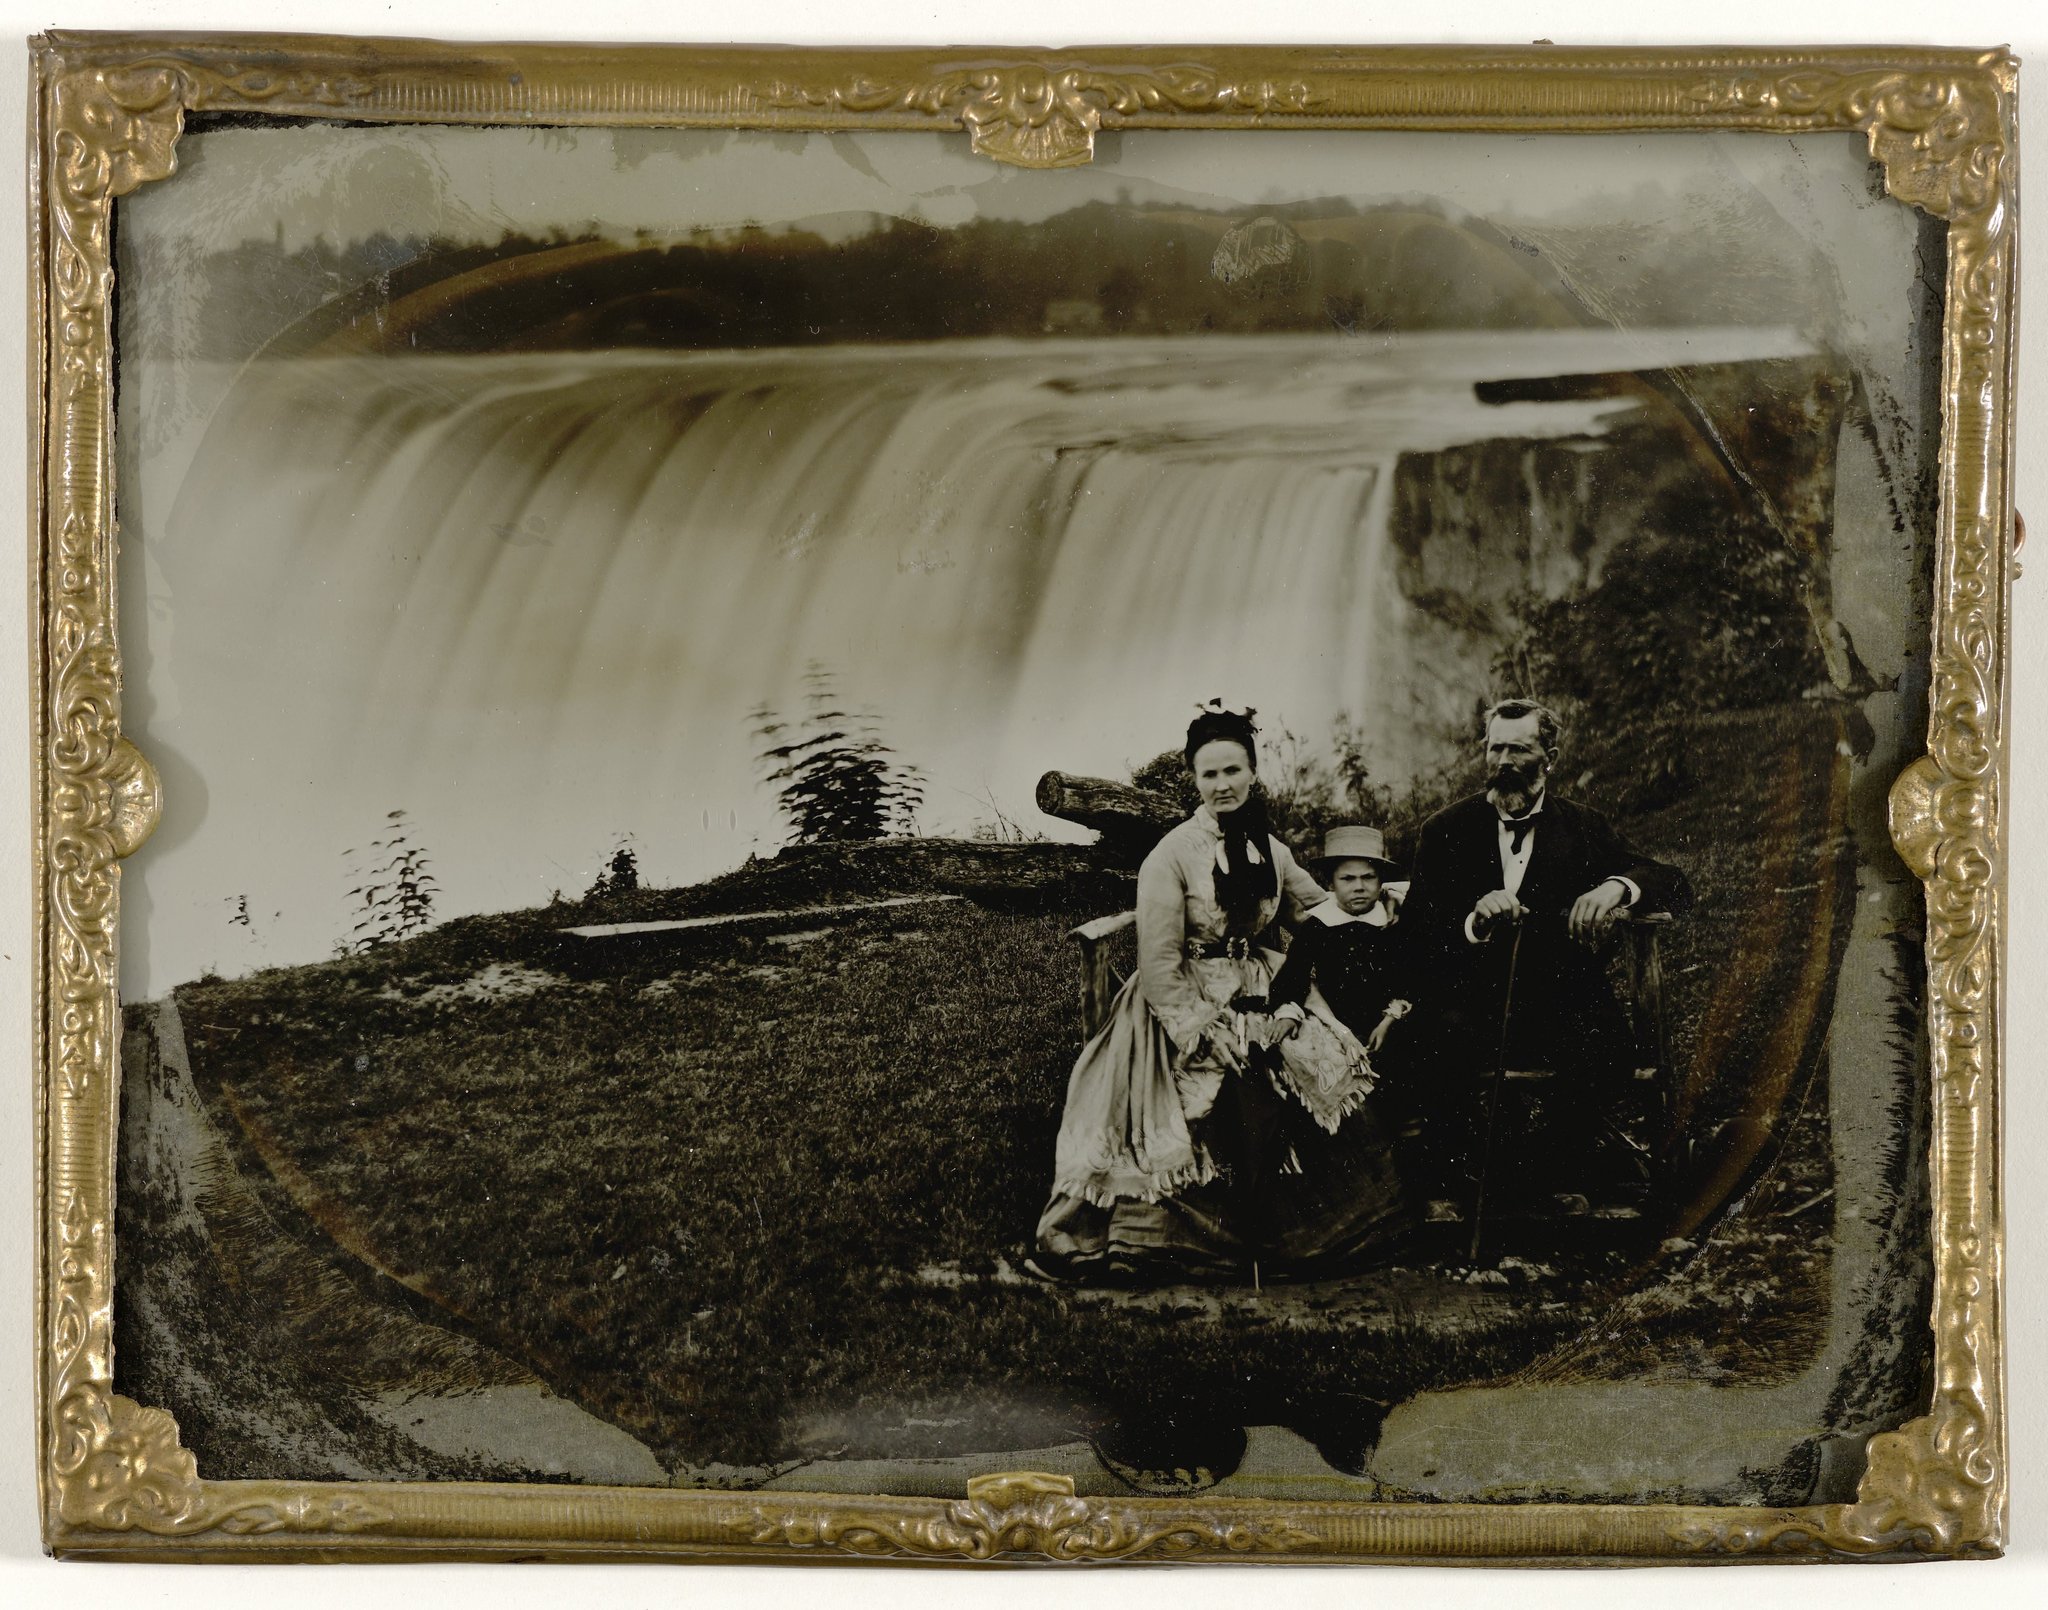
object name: photograph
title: Portrait of a Family Visiting Niagara Falls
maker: edward davis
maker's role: fotograaf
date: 1855-1860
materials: glass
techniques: ambrotype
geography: united states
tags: waterfall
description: Visiting the breathtaking Niagara Falls required wearing raingear. This family had itself portrayed twice by the ambrotypist: once with and once without raincoats in the exact same spot. The famous tourist attraction buzzed with photographic activity. Visitors and travellers were portrayed by all manner of photographers. And pictures of the Falls were for sale everywhere.